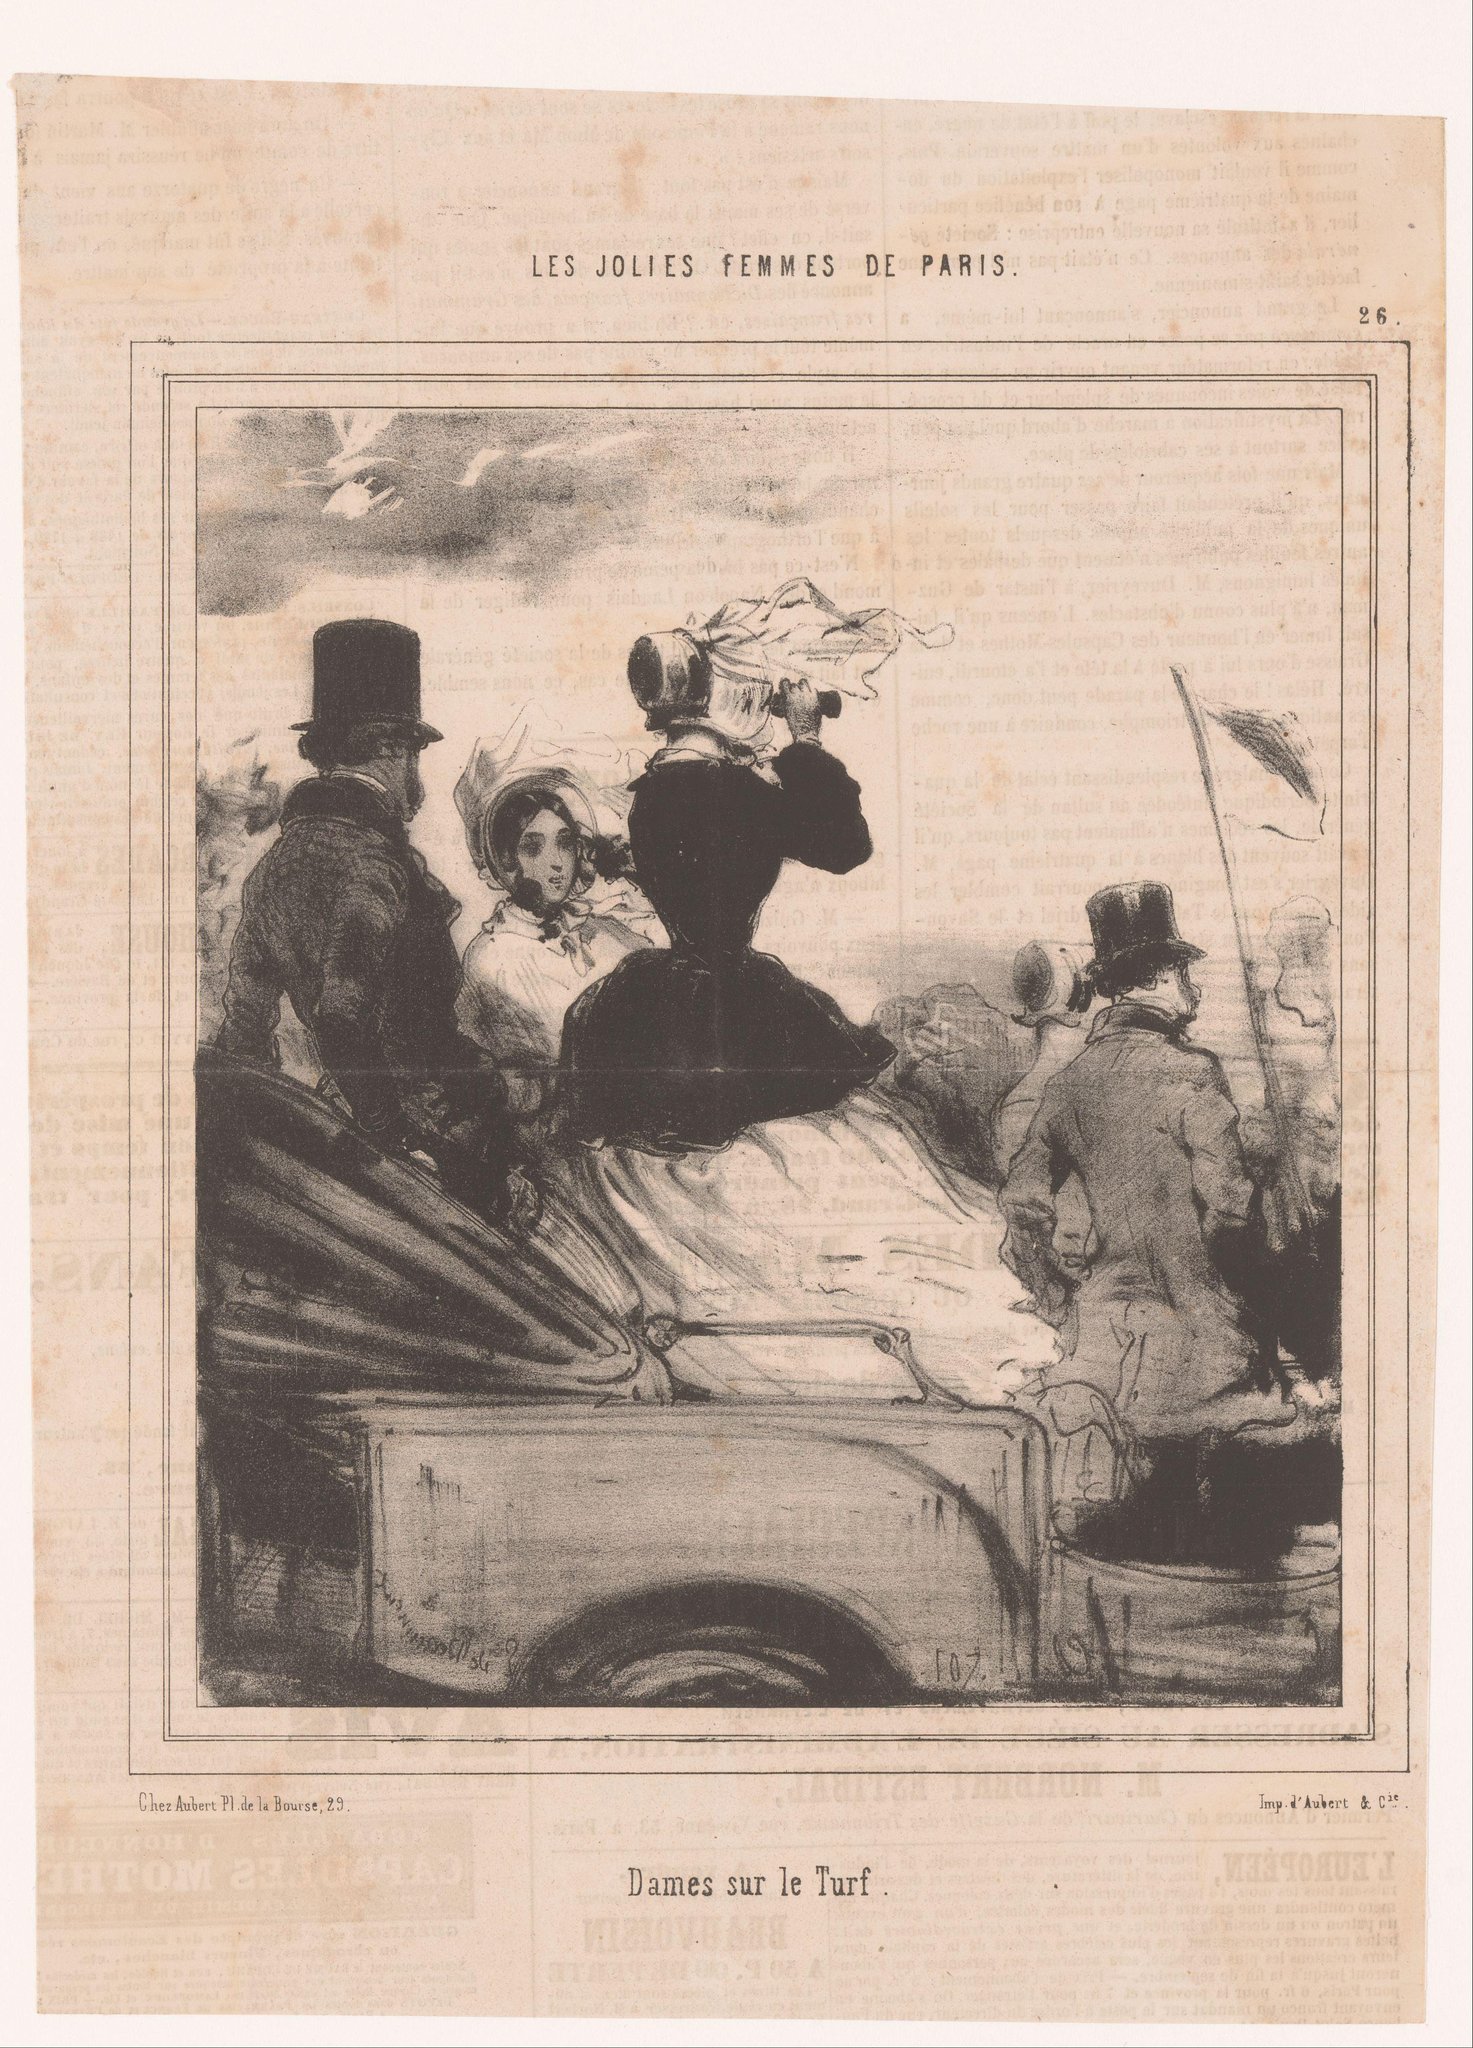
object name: cartoon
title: Mooie Parisiennes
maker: edouard de beaumont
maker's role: draughtsman, painter, print maker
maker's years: 1812-1888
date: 1846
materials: paper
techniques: lithograph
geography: paris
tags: horse-racing, binoculars, spy-glass, etc., paris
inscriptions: collector's mark: Lugt 2228a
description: Prent gebruikt voor: Le Charivari, 1846.